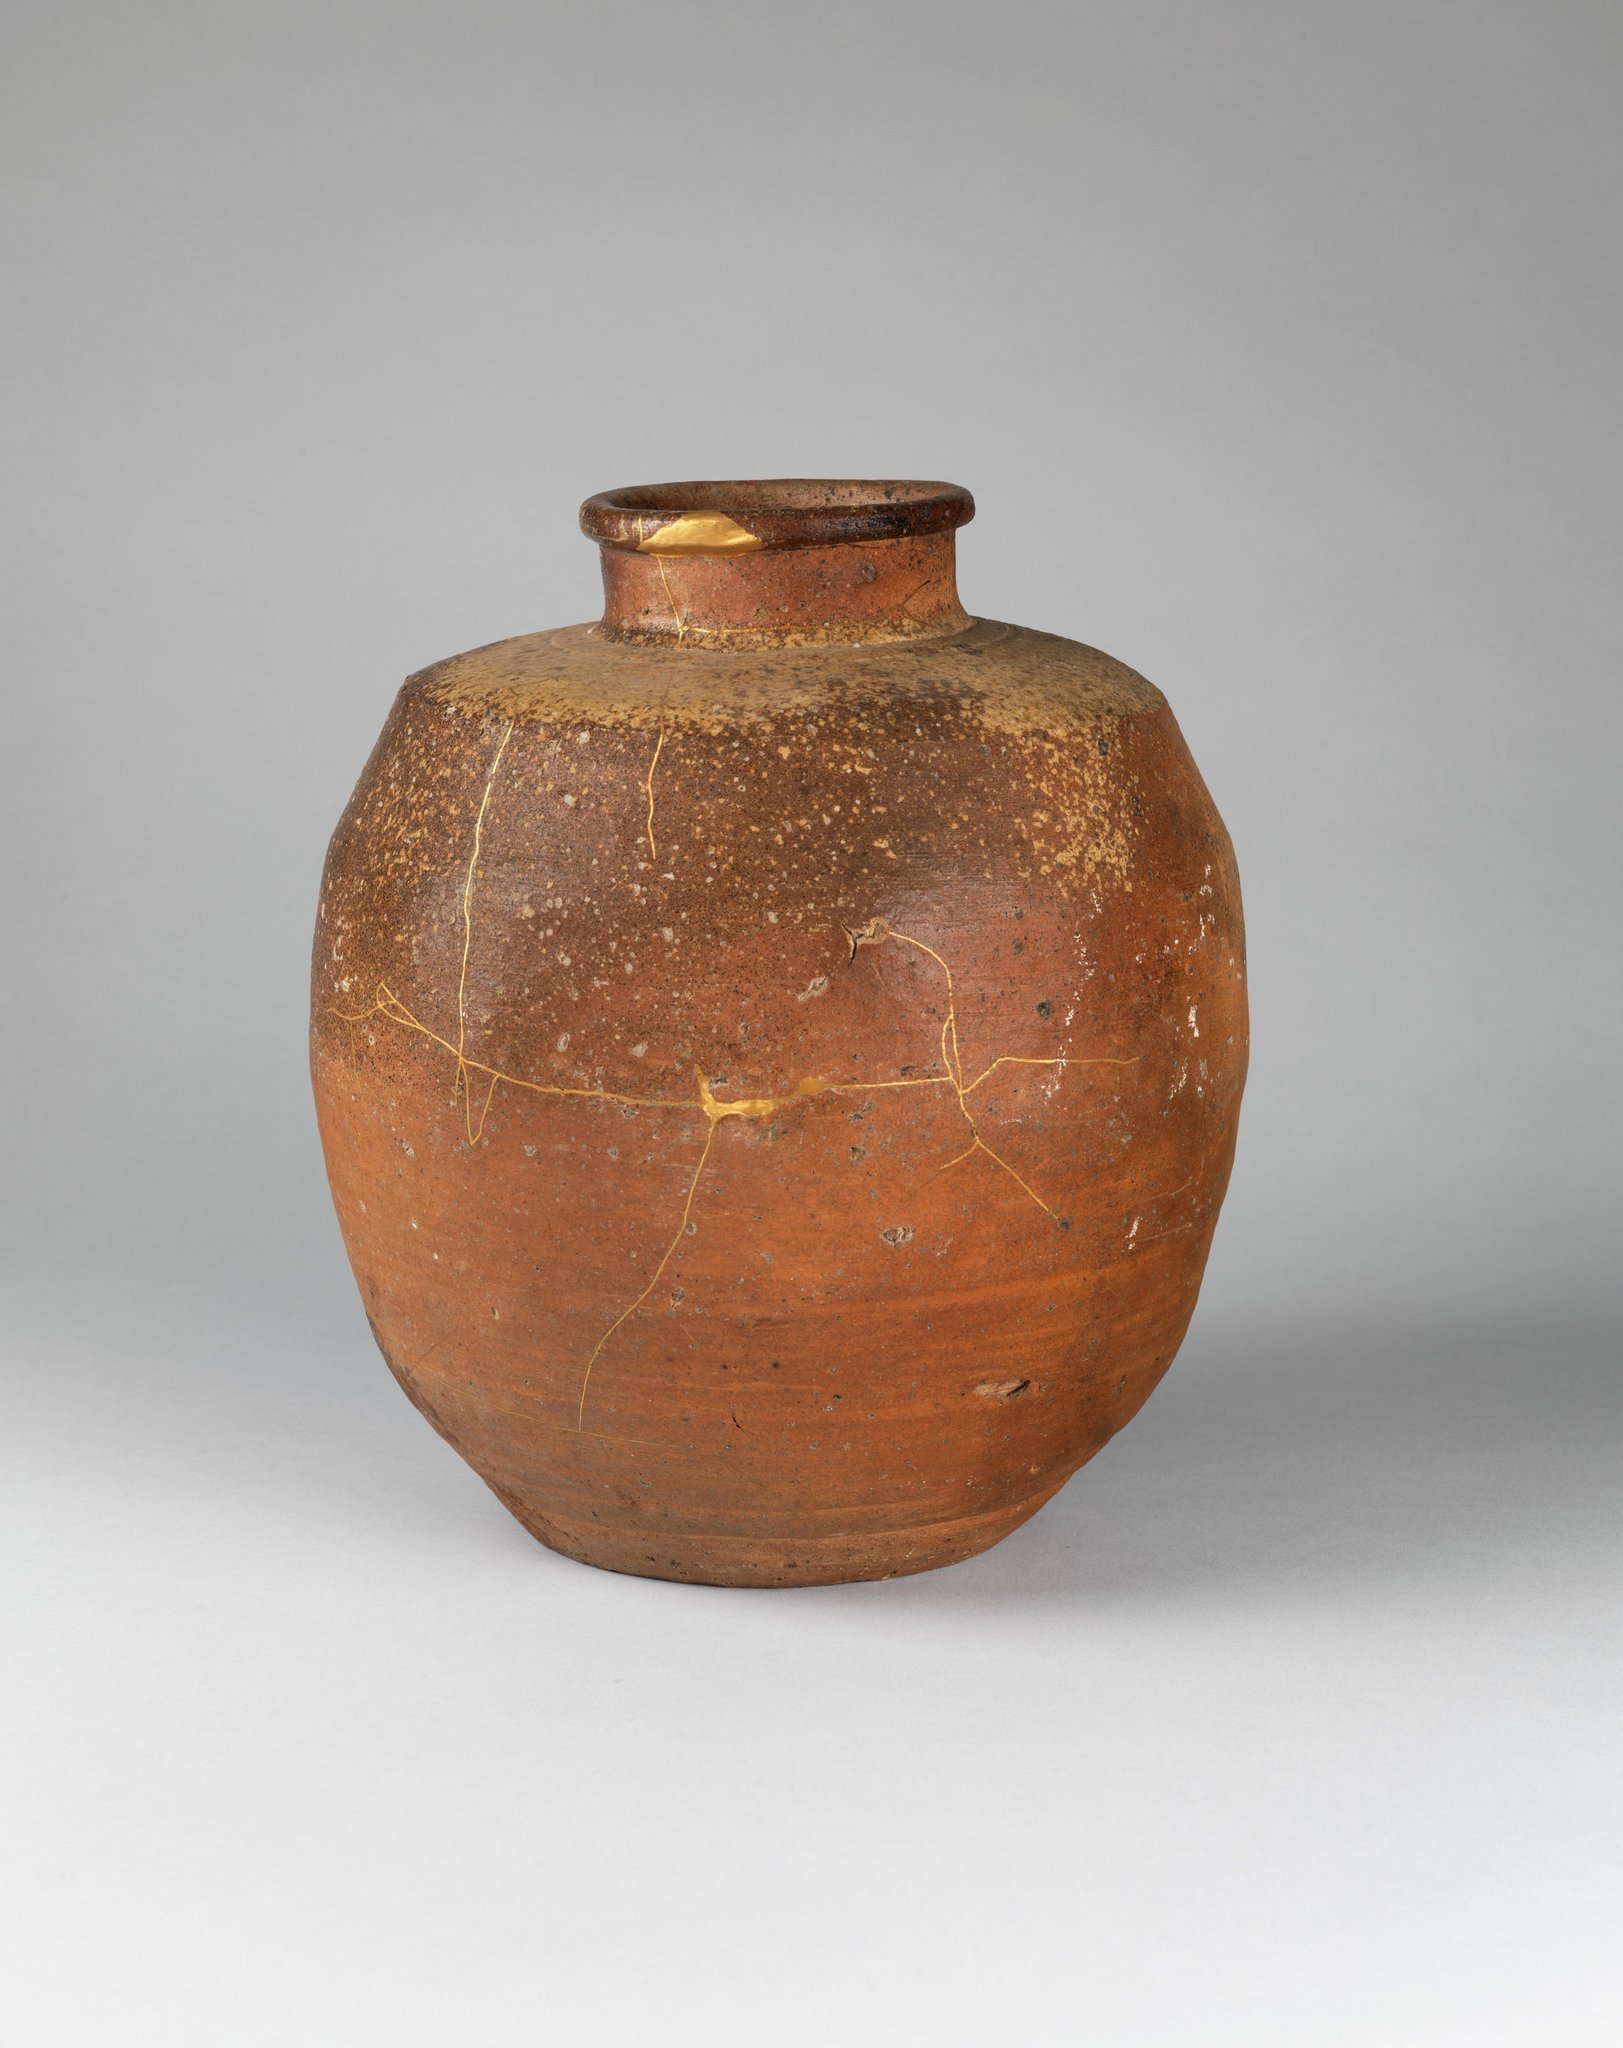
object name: jar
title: Shigaraki Jar (Tsubo)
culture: japanese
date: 1601-1700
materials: wood, glaze, gold, lacquer, stoneware